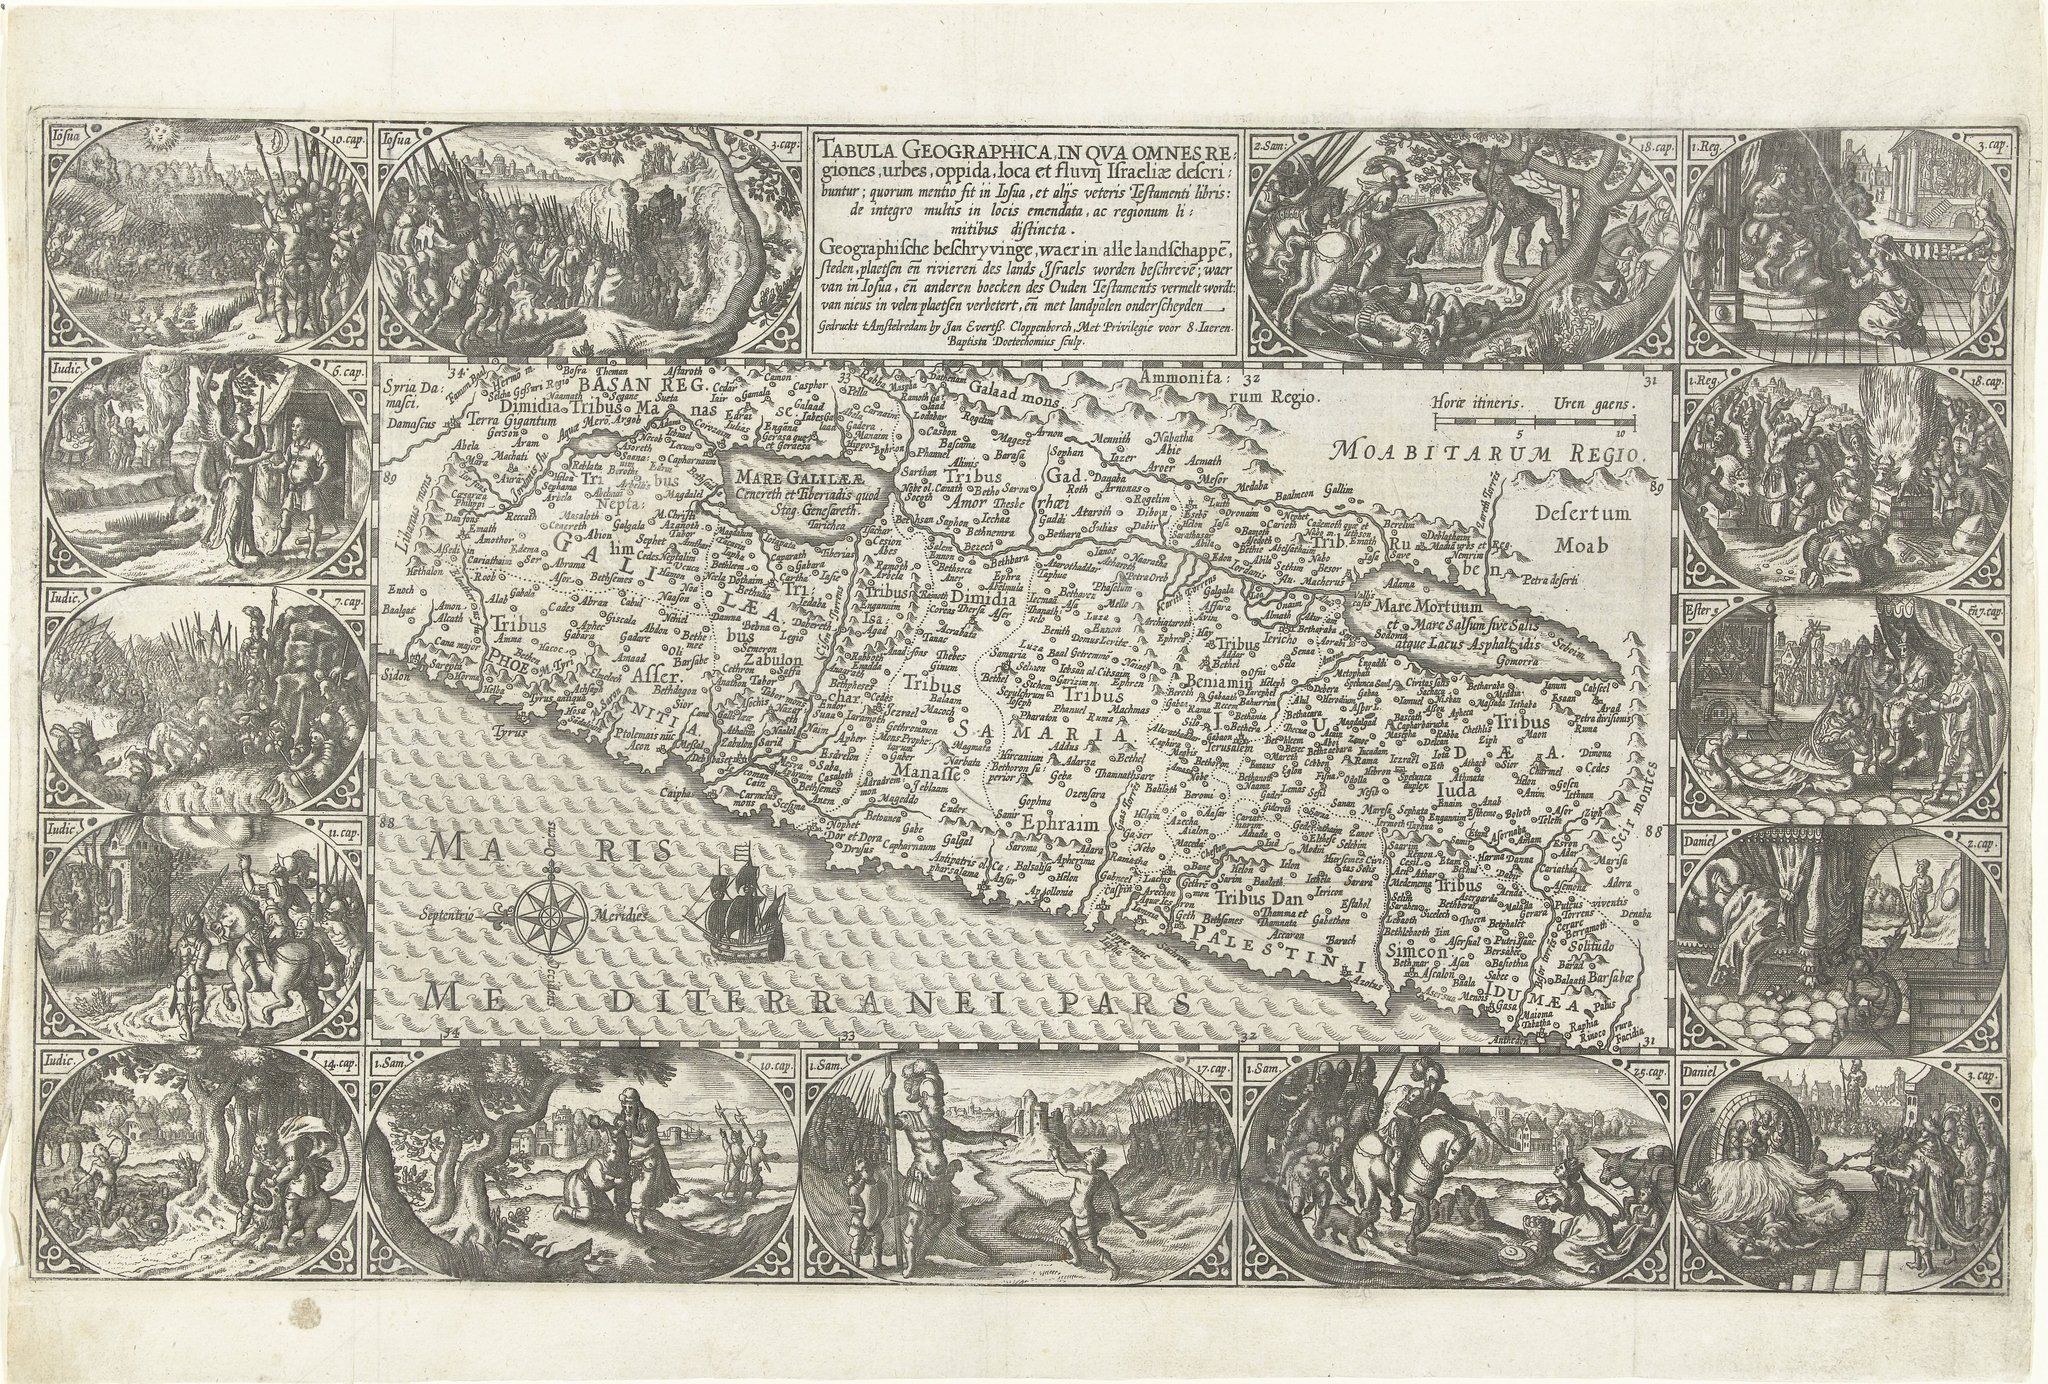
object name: map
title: Bijbelkaarten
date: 1603-1604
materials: paper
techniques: engraving, etching, letterpress printing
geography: amsterdam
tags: maps of separate countries or regions, old testament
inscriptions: collector's mark: Lugt 2228, collector's mark: Lugt 2760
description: Kaart van het Heilige Land met het meer van Tiberias en de Dode Zee. Om de kaart 15 cartouches met scénes uit het Oude Testament.